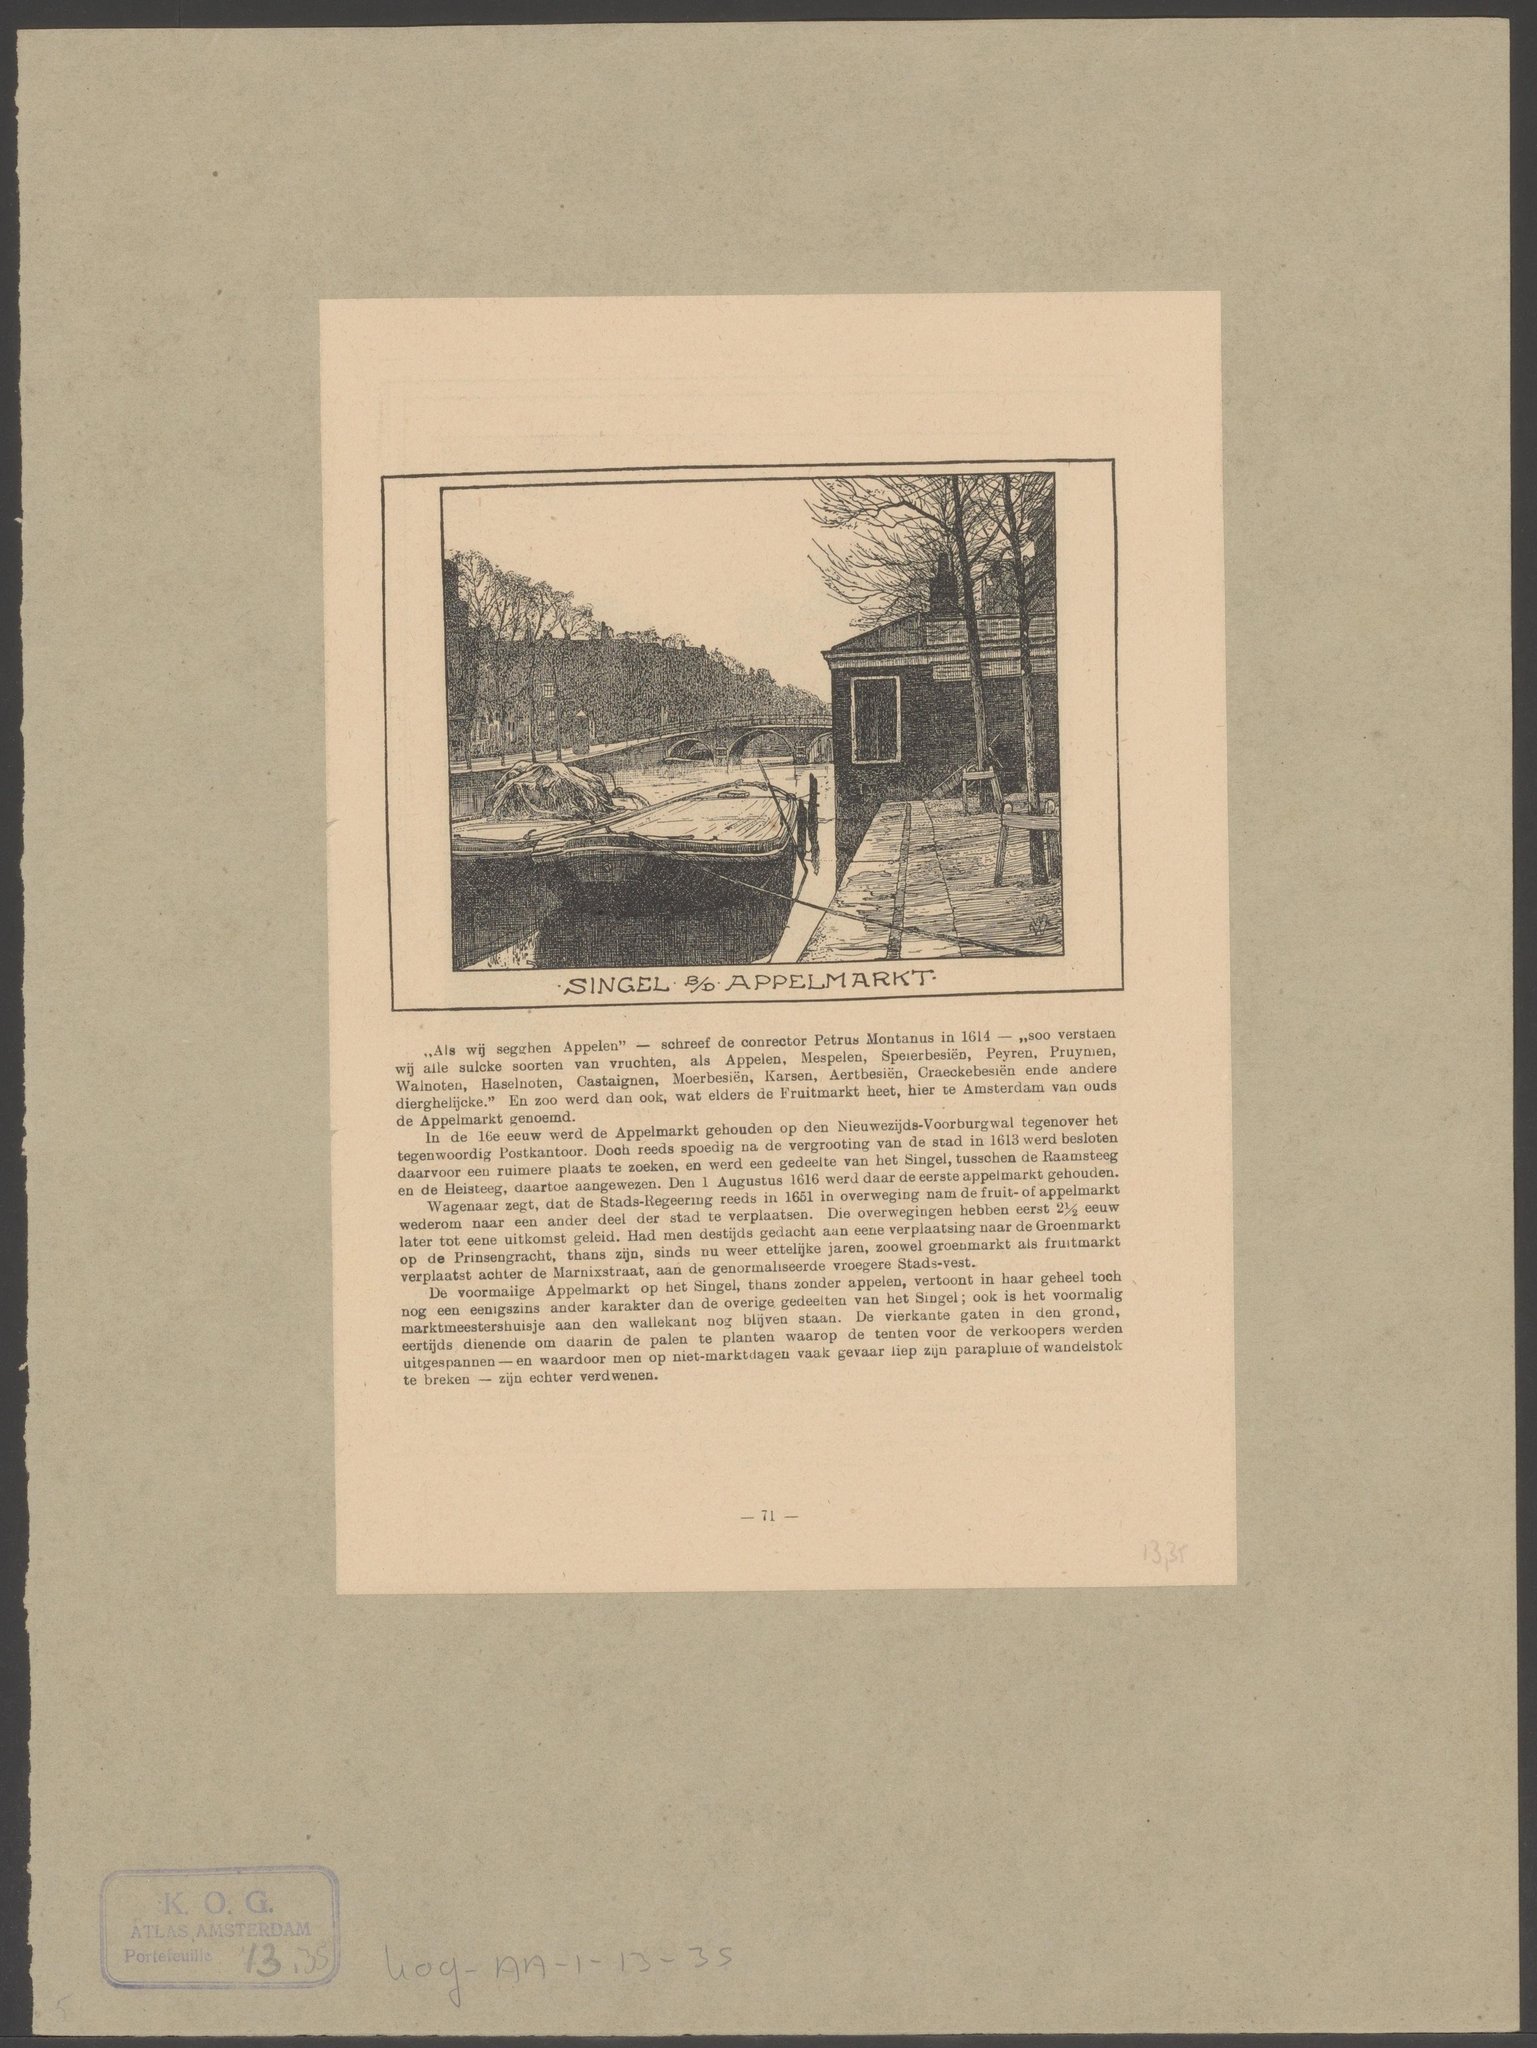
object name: page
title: Oud-Amsterdam 100 Stadsgezichten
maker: willem wenckebach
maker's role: designer, draughtsman, painter, print maker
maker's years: 1860-1937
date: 1870-1923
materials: paper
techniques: letterpress printing, line block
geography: amsterdam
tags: city-view in general; 'veduta', canal, tow-boat, towing-barge, bridge in city across river, canal, etc., street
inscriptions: collector's mark: ‘13,35’ Lugt 1641b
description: Fotomechanische afdruk uit een editie van Het Nieuws van den Dag, mogelijk uit de serie: Oud-Amsterdam 100 Stadsgezichten.